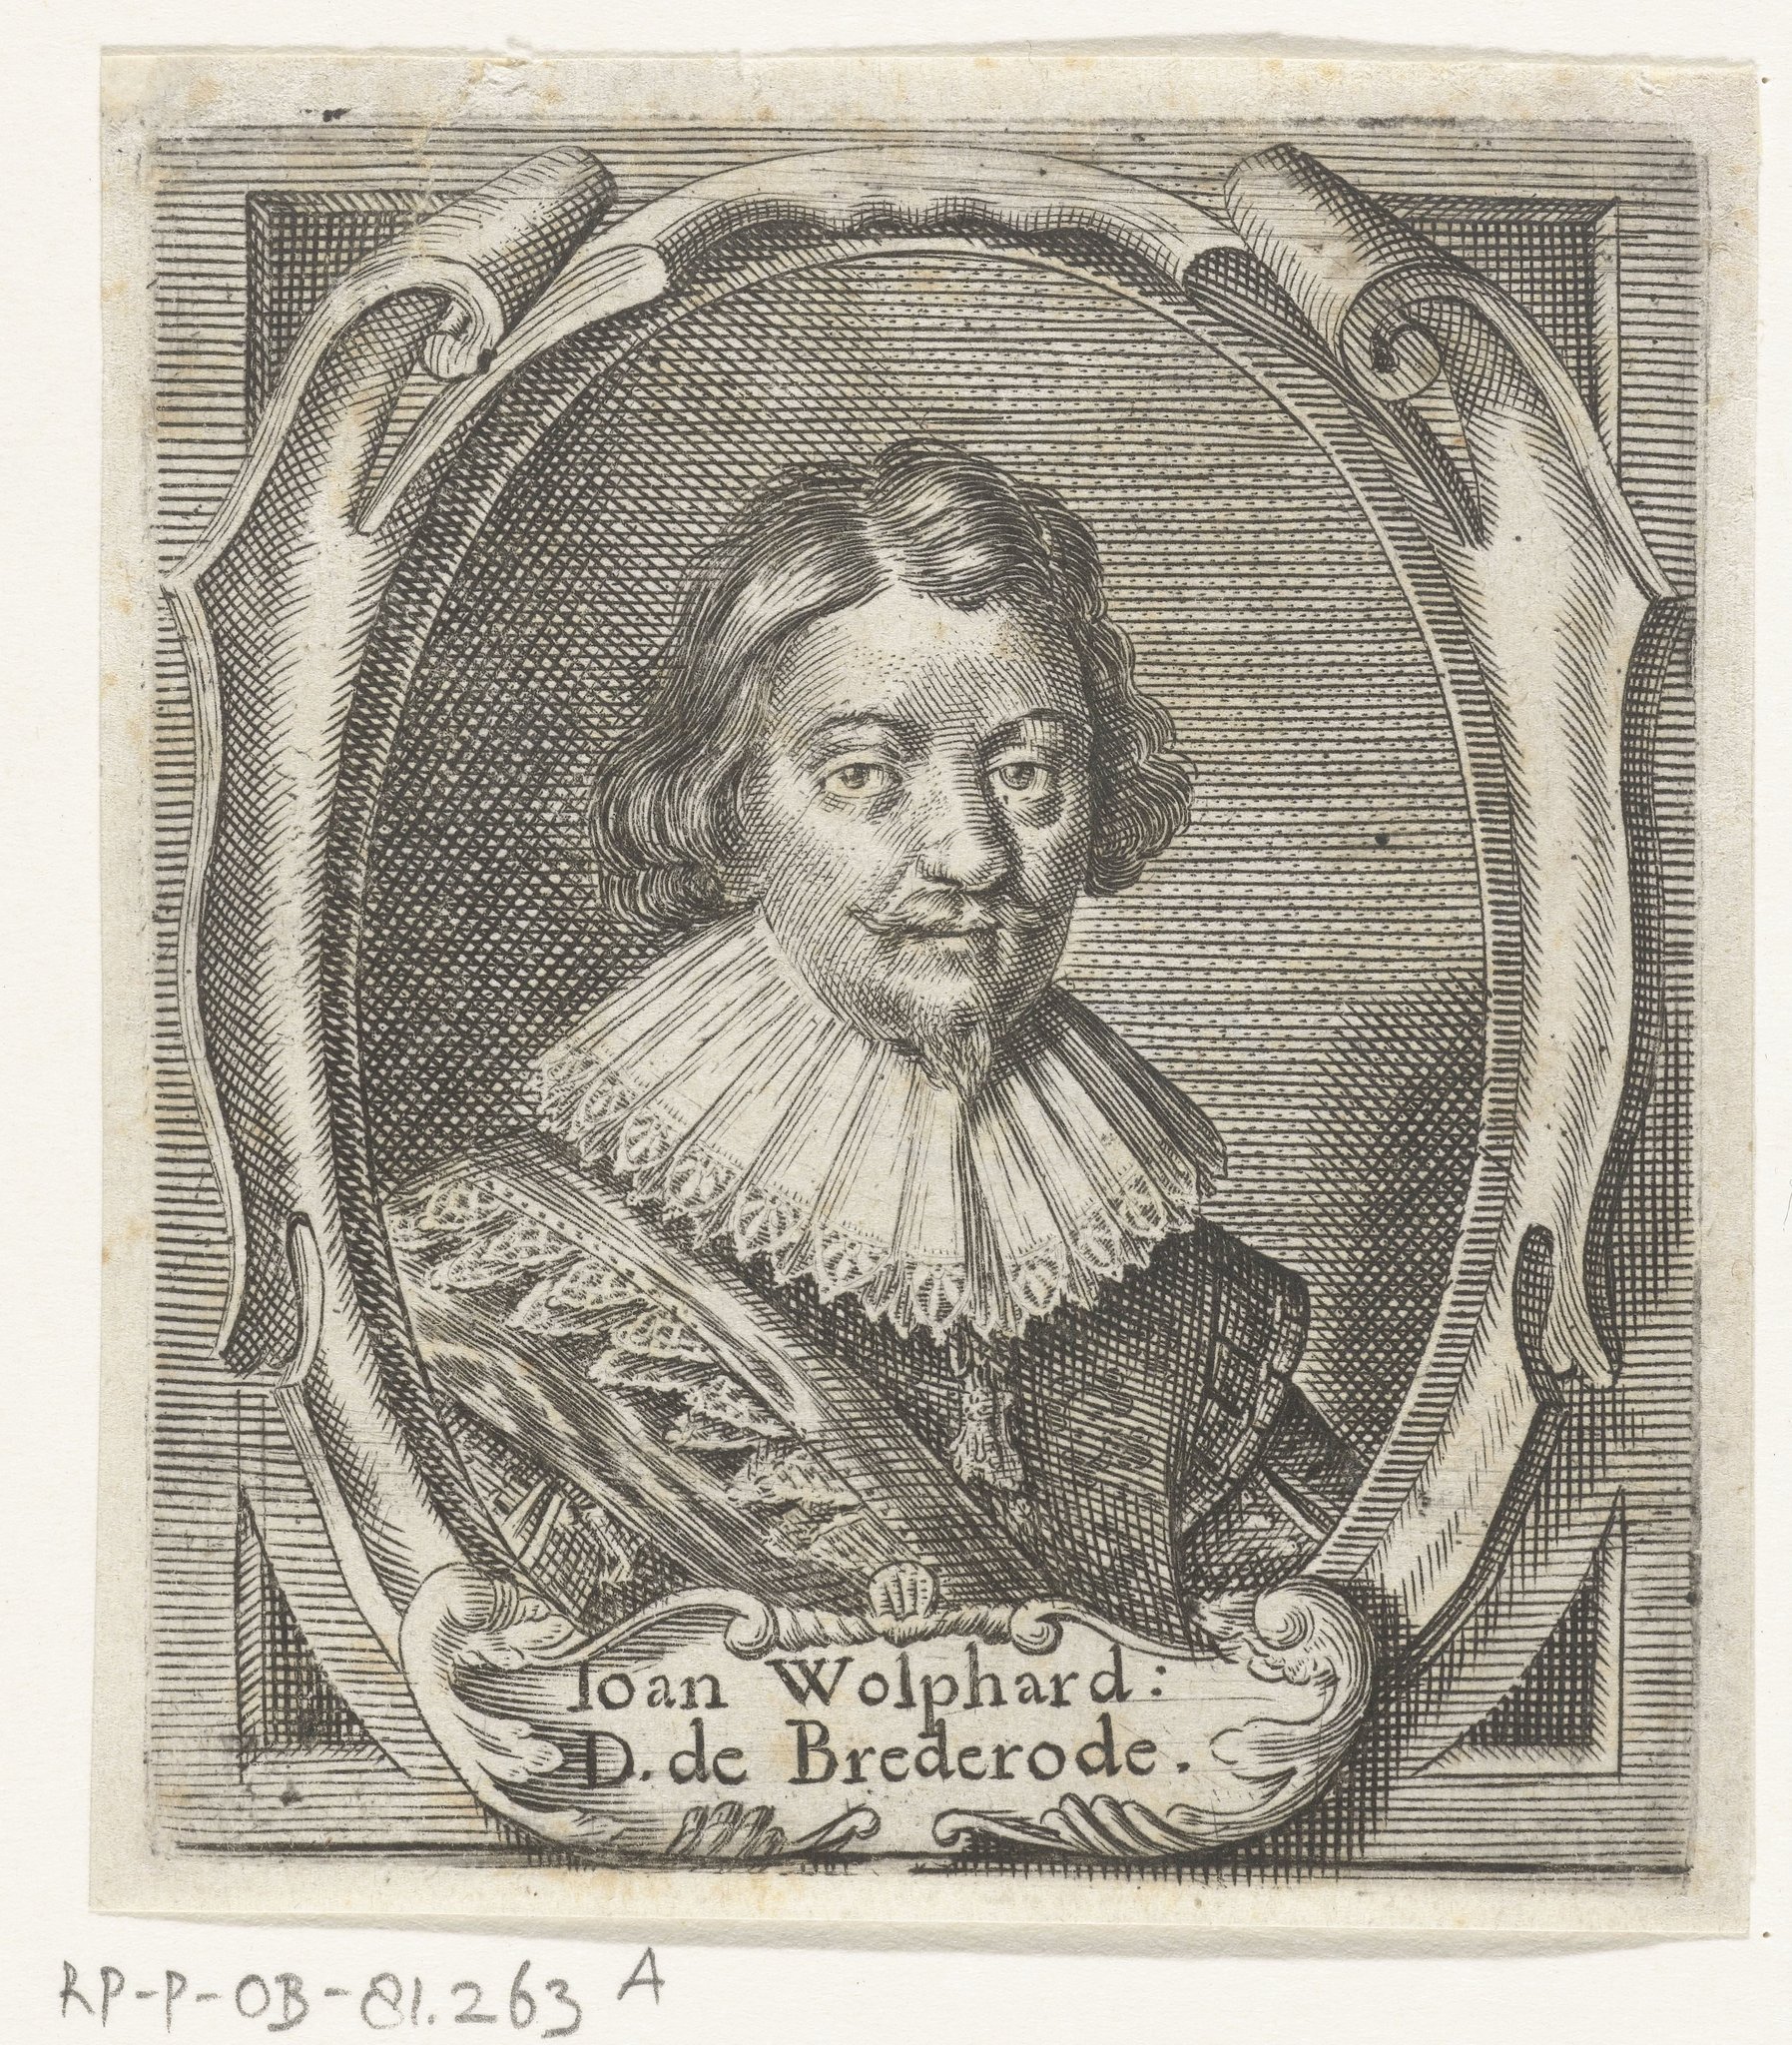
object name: print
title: Portret van Joan Wolfert van Brederode, heer van Vianen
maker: crispijn van de passe (ii)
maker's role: draughtsman, print maker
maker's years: 1594-1670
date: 1632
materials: paper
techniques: engraving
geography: northern netherlands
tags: vianen, maarschalk, joan wolfert van brederode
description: Portret van Joan Wolfert van Brederode, heer van Vianen. Deze portretten van veldheren in dienst van de stadhouder zijn gebruikt als onderdeel van de allegorie met stadhouder Frederik Hendrik uit 1632.